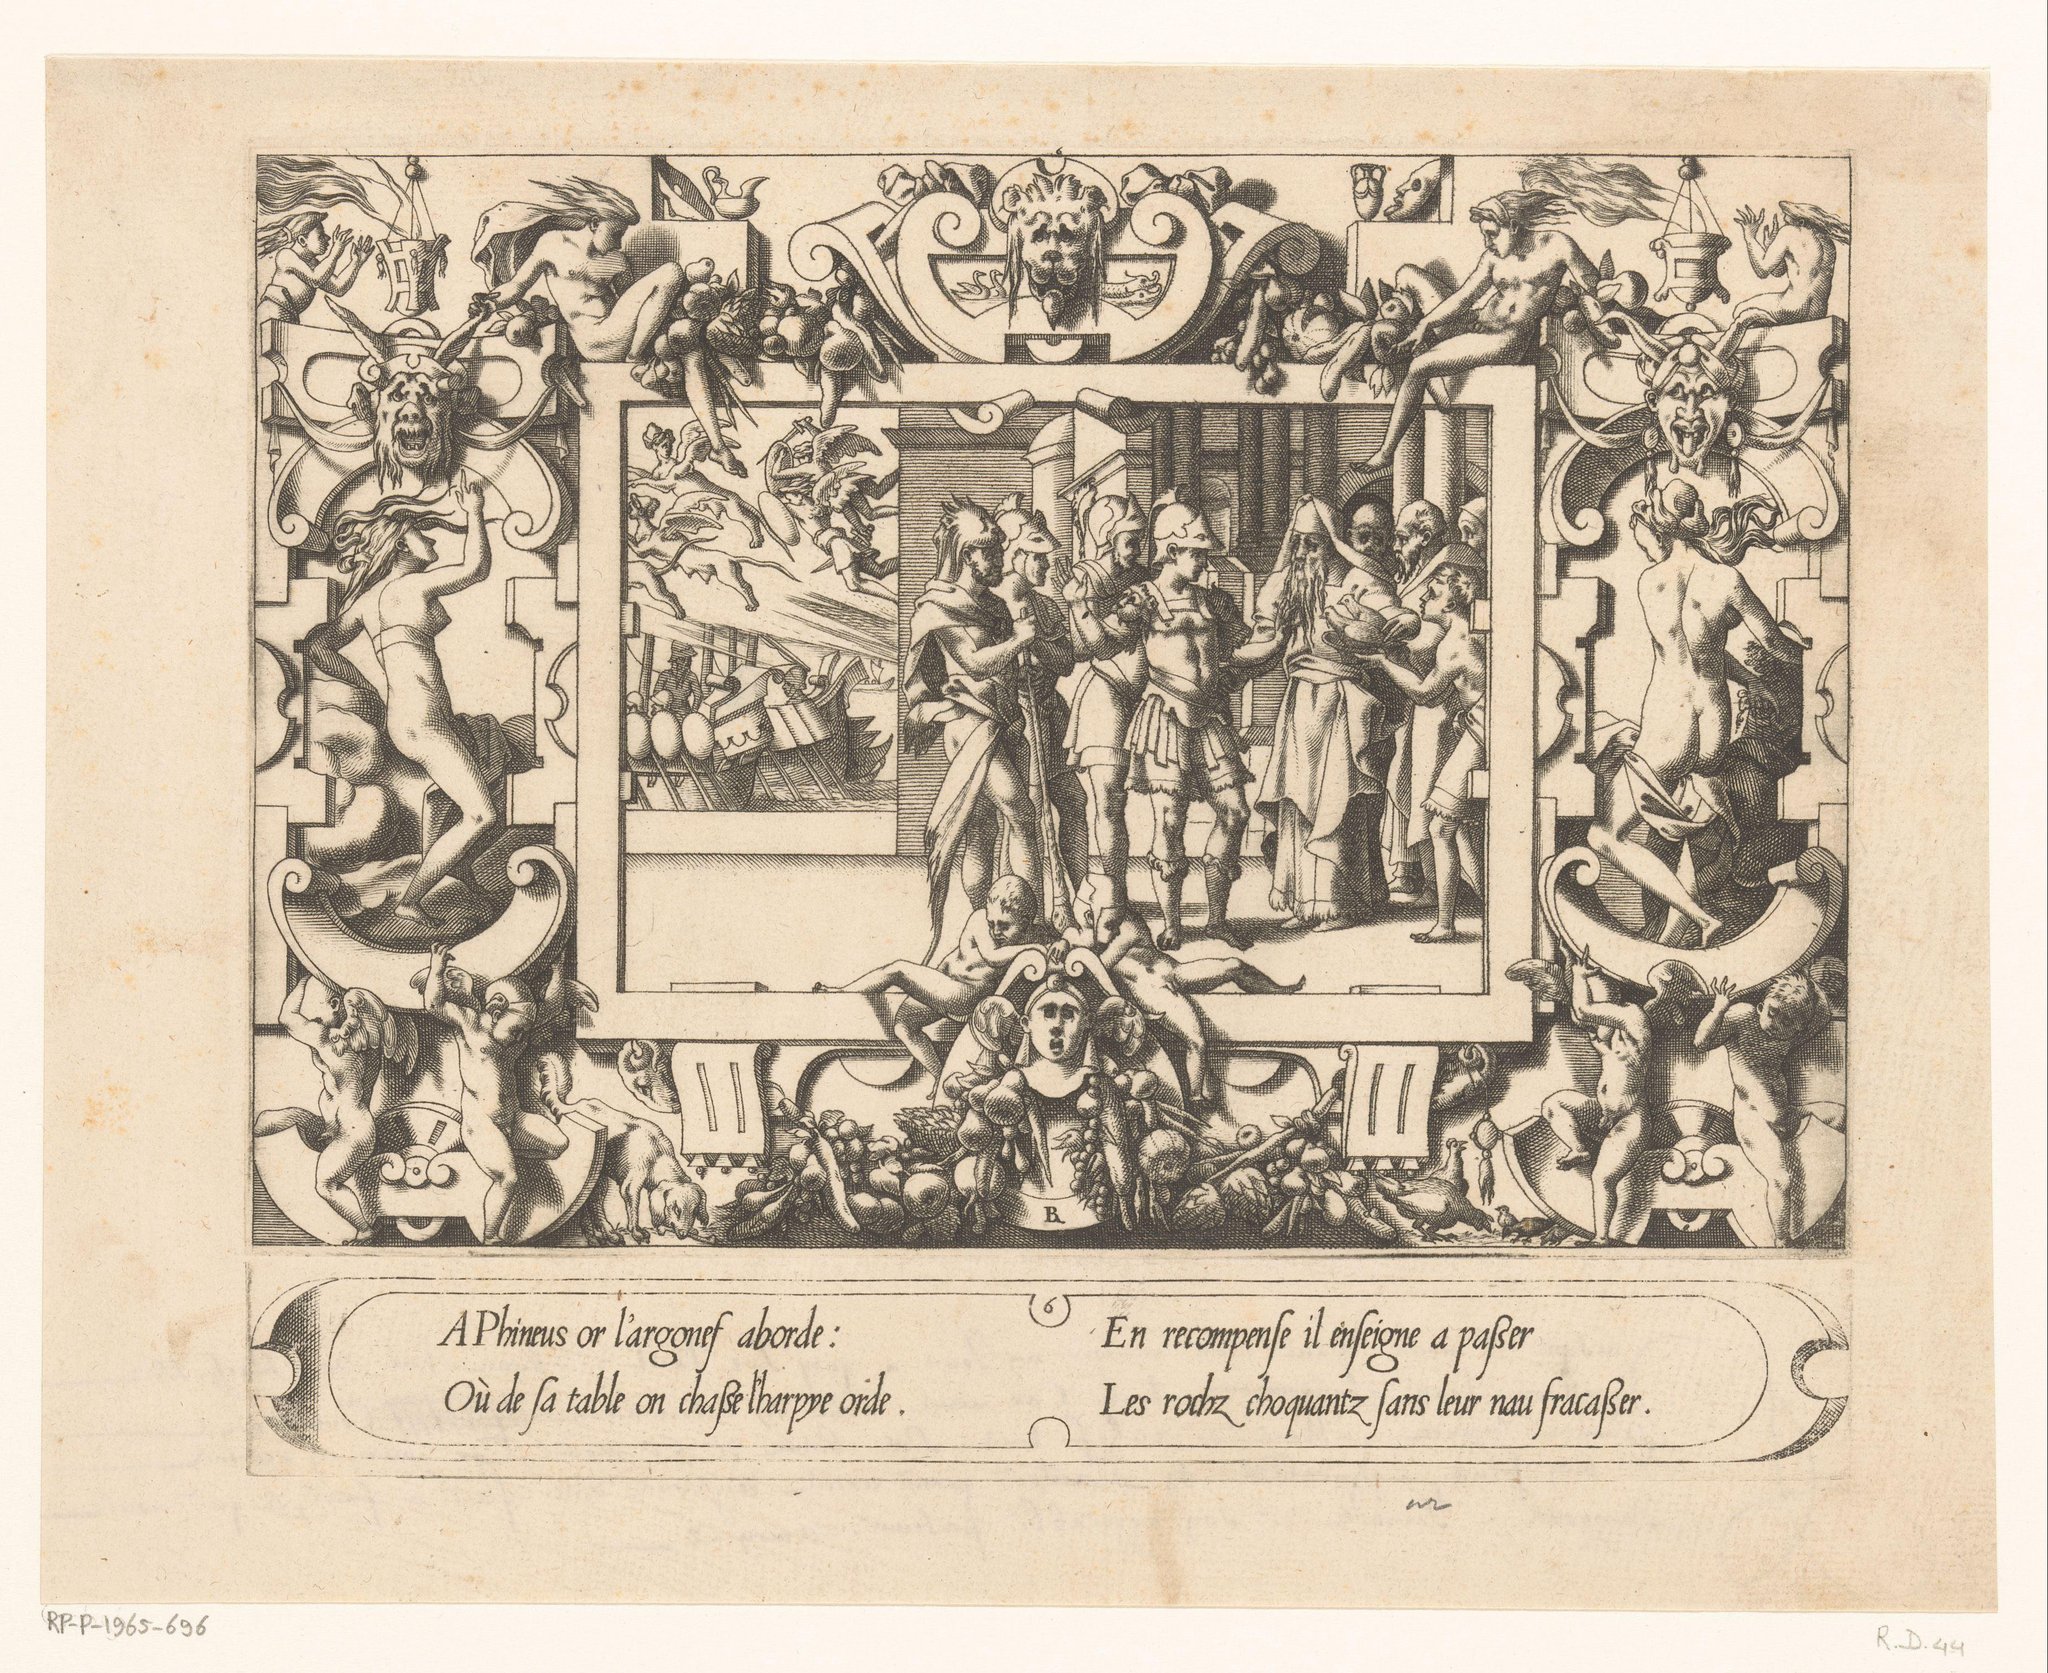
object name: print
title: Argonauten bezoeken Phineus en verjagen de Harpijen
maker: rené boyvin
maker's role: print maker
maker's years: 1525-1598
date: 1563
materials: paper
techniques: engraving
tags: the argonauts with phineus, the story of the argonauts: the quest for the golden fleece, calais and zetes chase away the harpies that plagued phineus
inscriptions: collector's mark: Lugt 2228, collector's mark: Lugt 2760, inscription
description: Phineus biedt de Argonauten twee duiven aan en geeft ze instructies hoe te navigeren. Het geheel wordt gekaderd door een ornamentele lijst met putti en mythologische figuren. Onder de voorstelling vier regels onderschrift in het Frans.